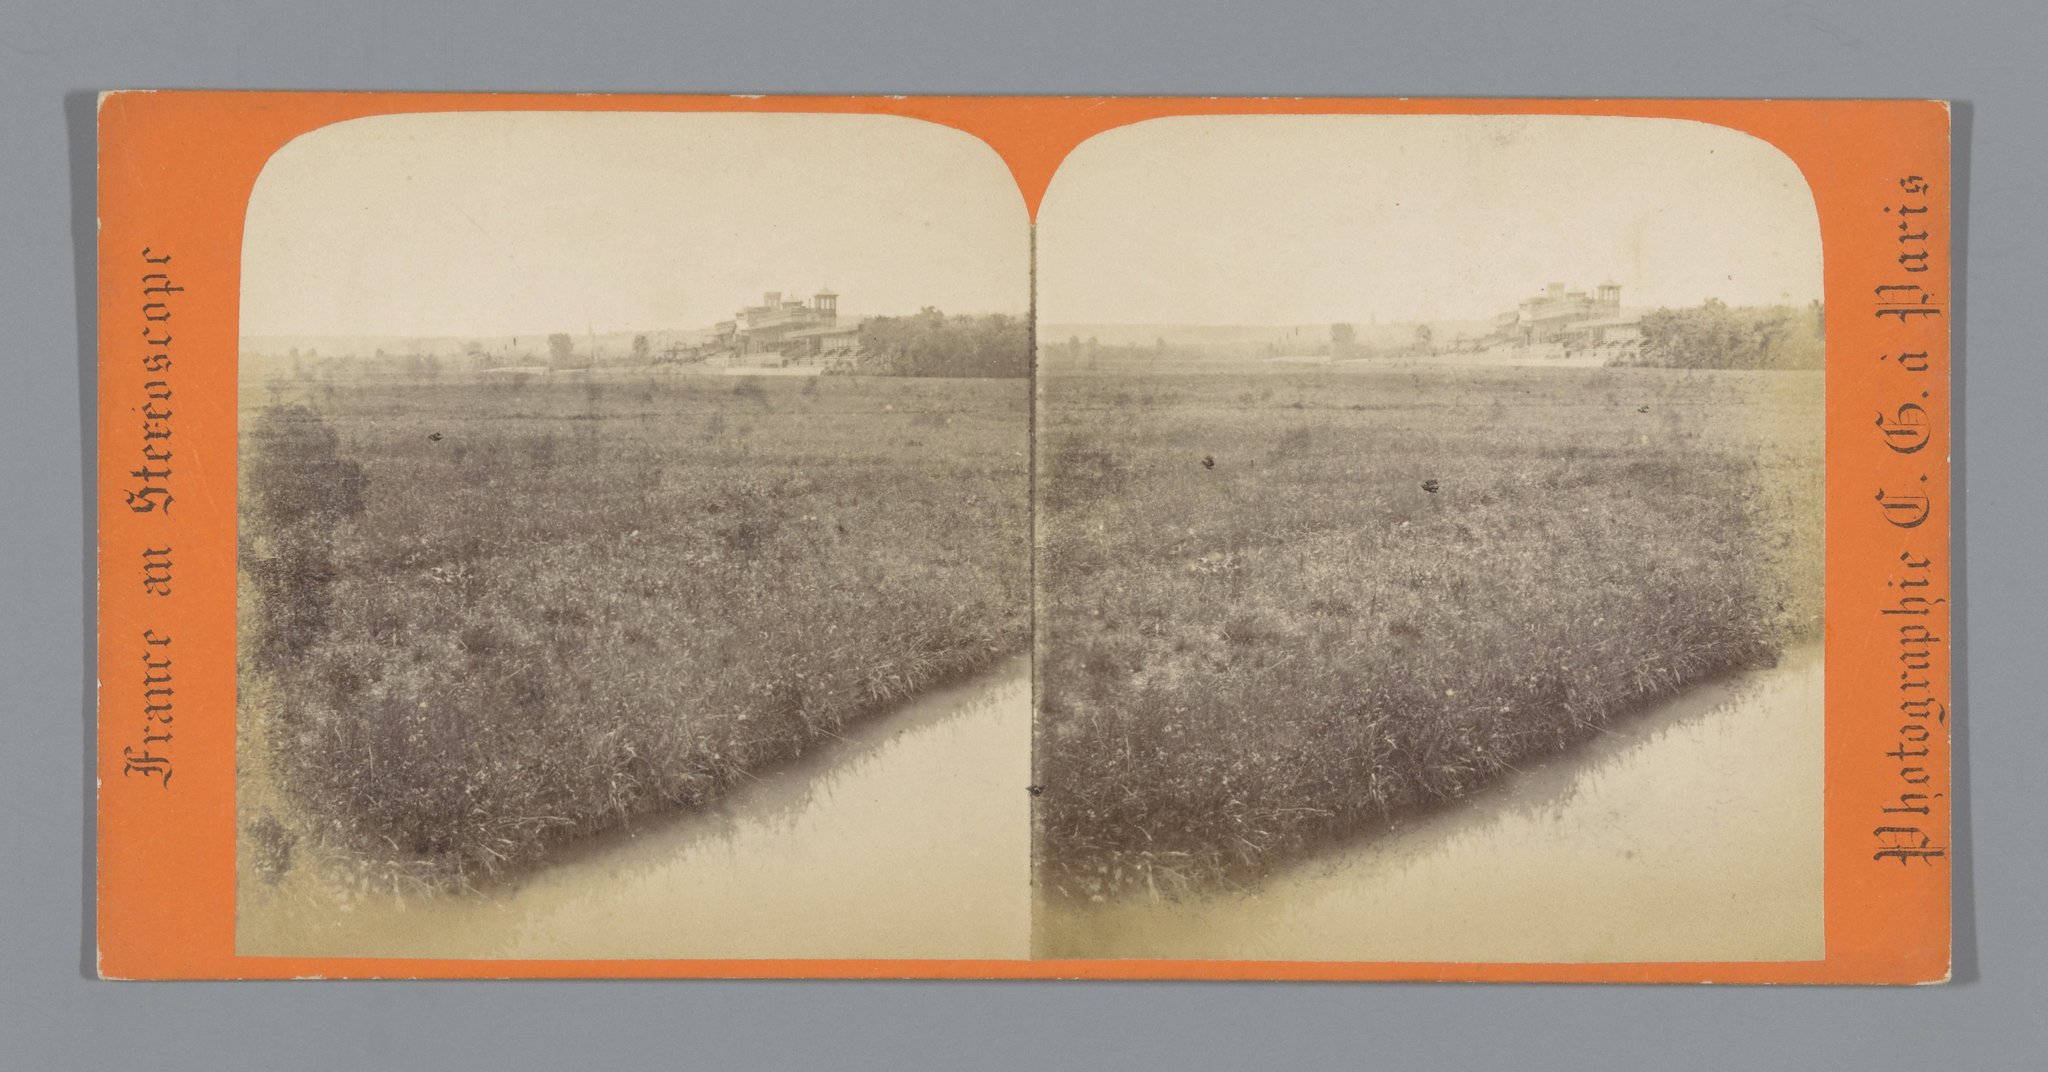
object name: stereograph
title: Renbaan in het Bois de Boulogne te Parijs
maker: charles gérard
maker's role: fotograaf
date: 1850-1875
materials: cardboard, photographic support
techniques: albumen print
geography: bois de boulogne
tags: race-track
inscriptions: inscription: ‘Champs de course au Bois de Boulogne Paris’